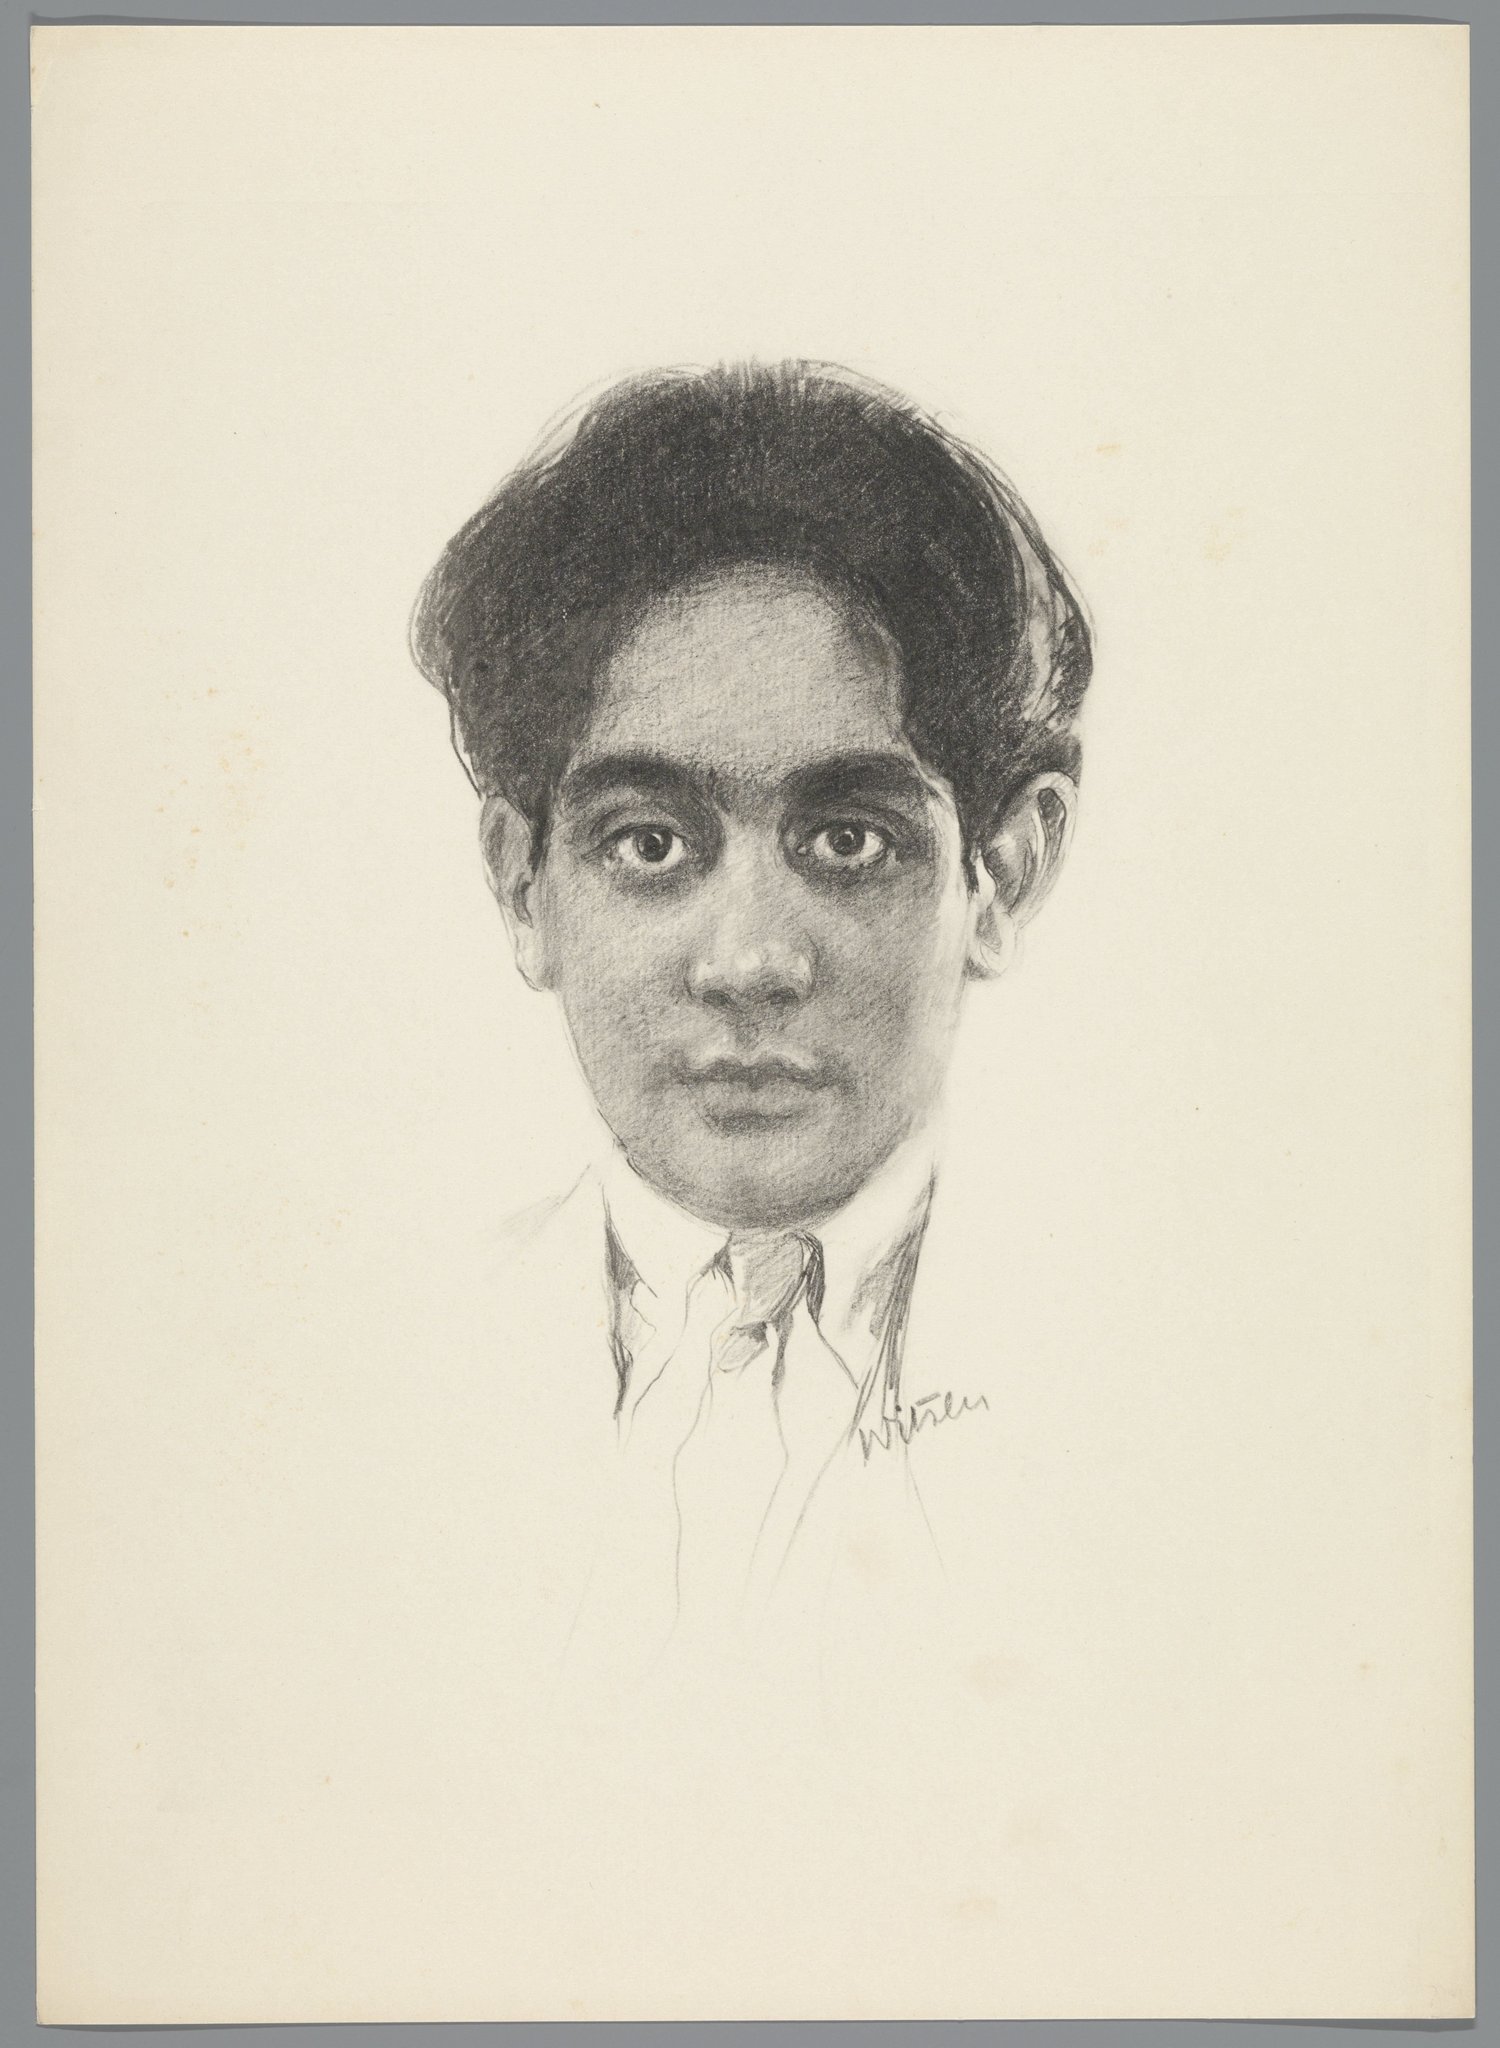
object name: reproduction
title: Reproductie van tekening met portret van Karamjit Singh Sahib Bahadur, prins van Kapurthala, door Willem Witsen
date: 1915-1916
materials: paper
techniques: photograph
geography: netherlands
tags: politician, historical persons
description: Voor schilderij van de geportretteerde door Witsen, zie collectie Dordrechts Museum (bruikleen RCE).